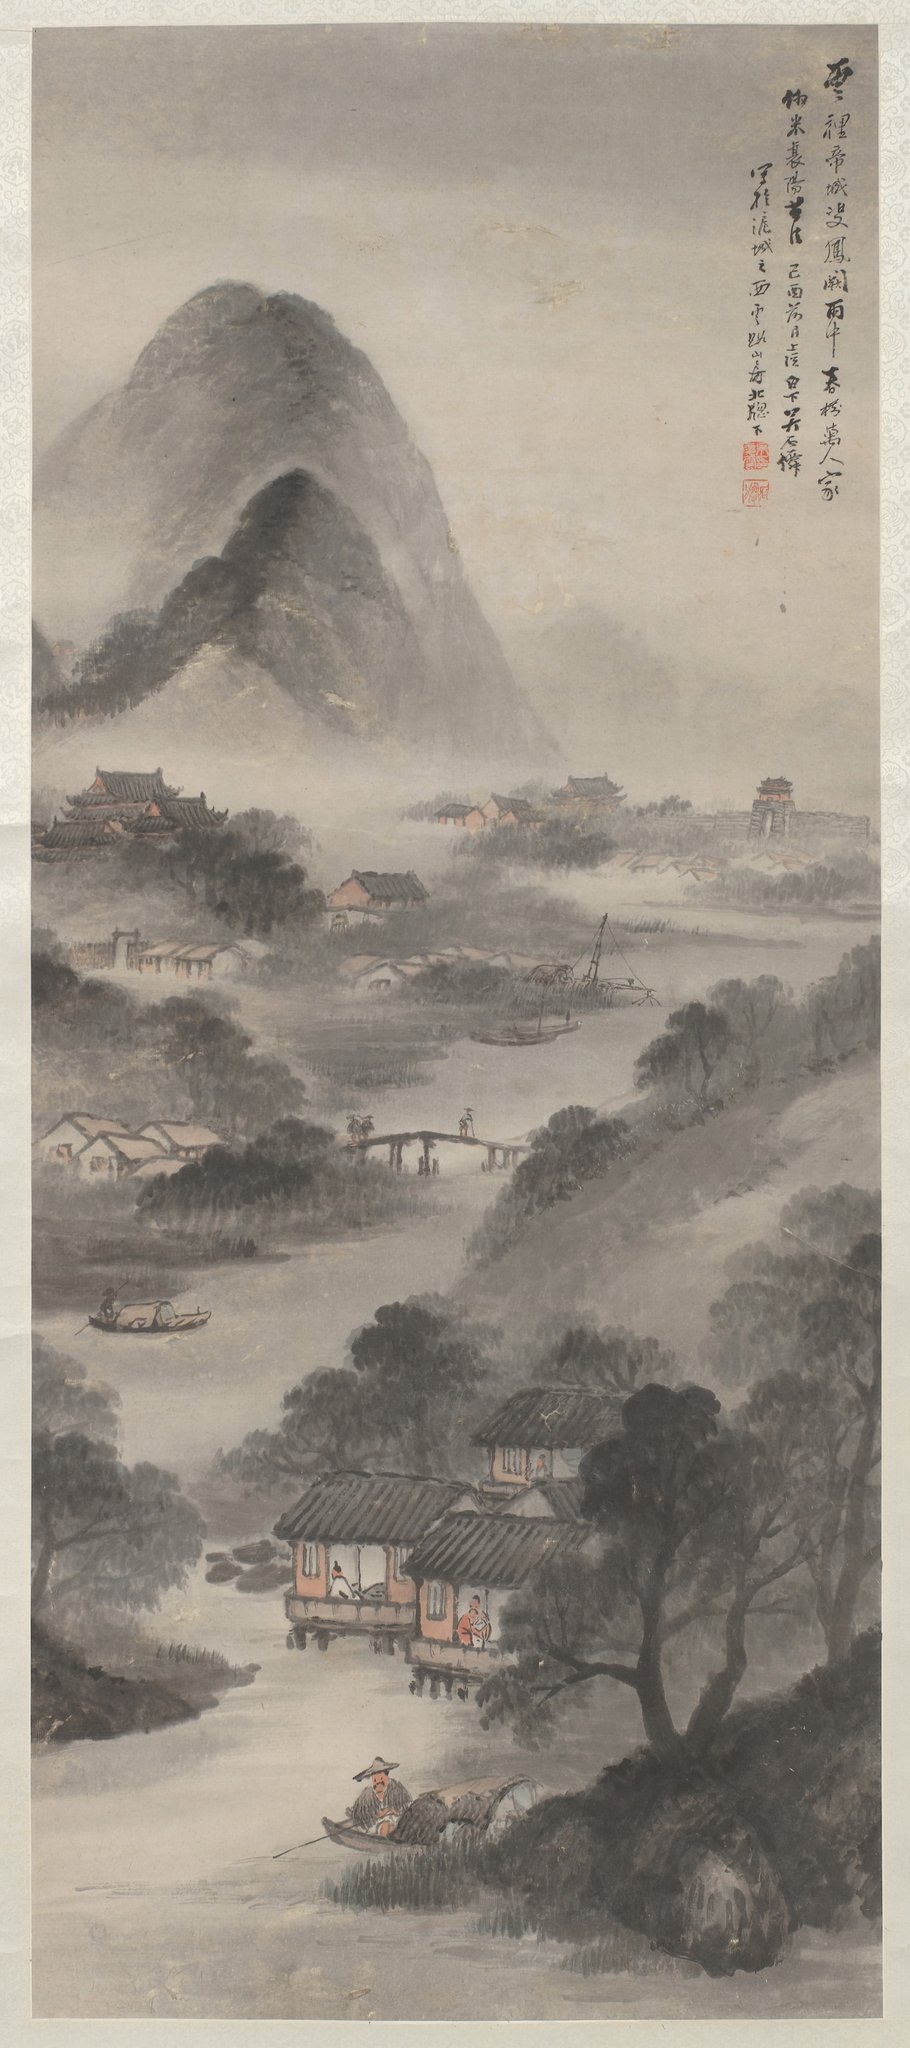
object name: hanging scroll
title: Landscape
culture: chinese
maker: wu shixian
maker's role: artist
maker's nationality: chinese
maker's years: -1916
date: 1909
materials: ink, paper